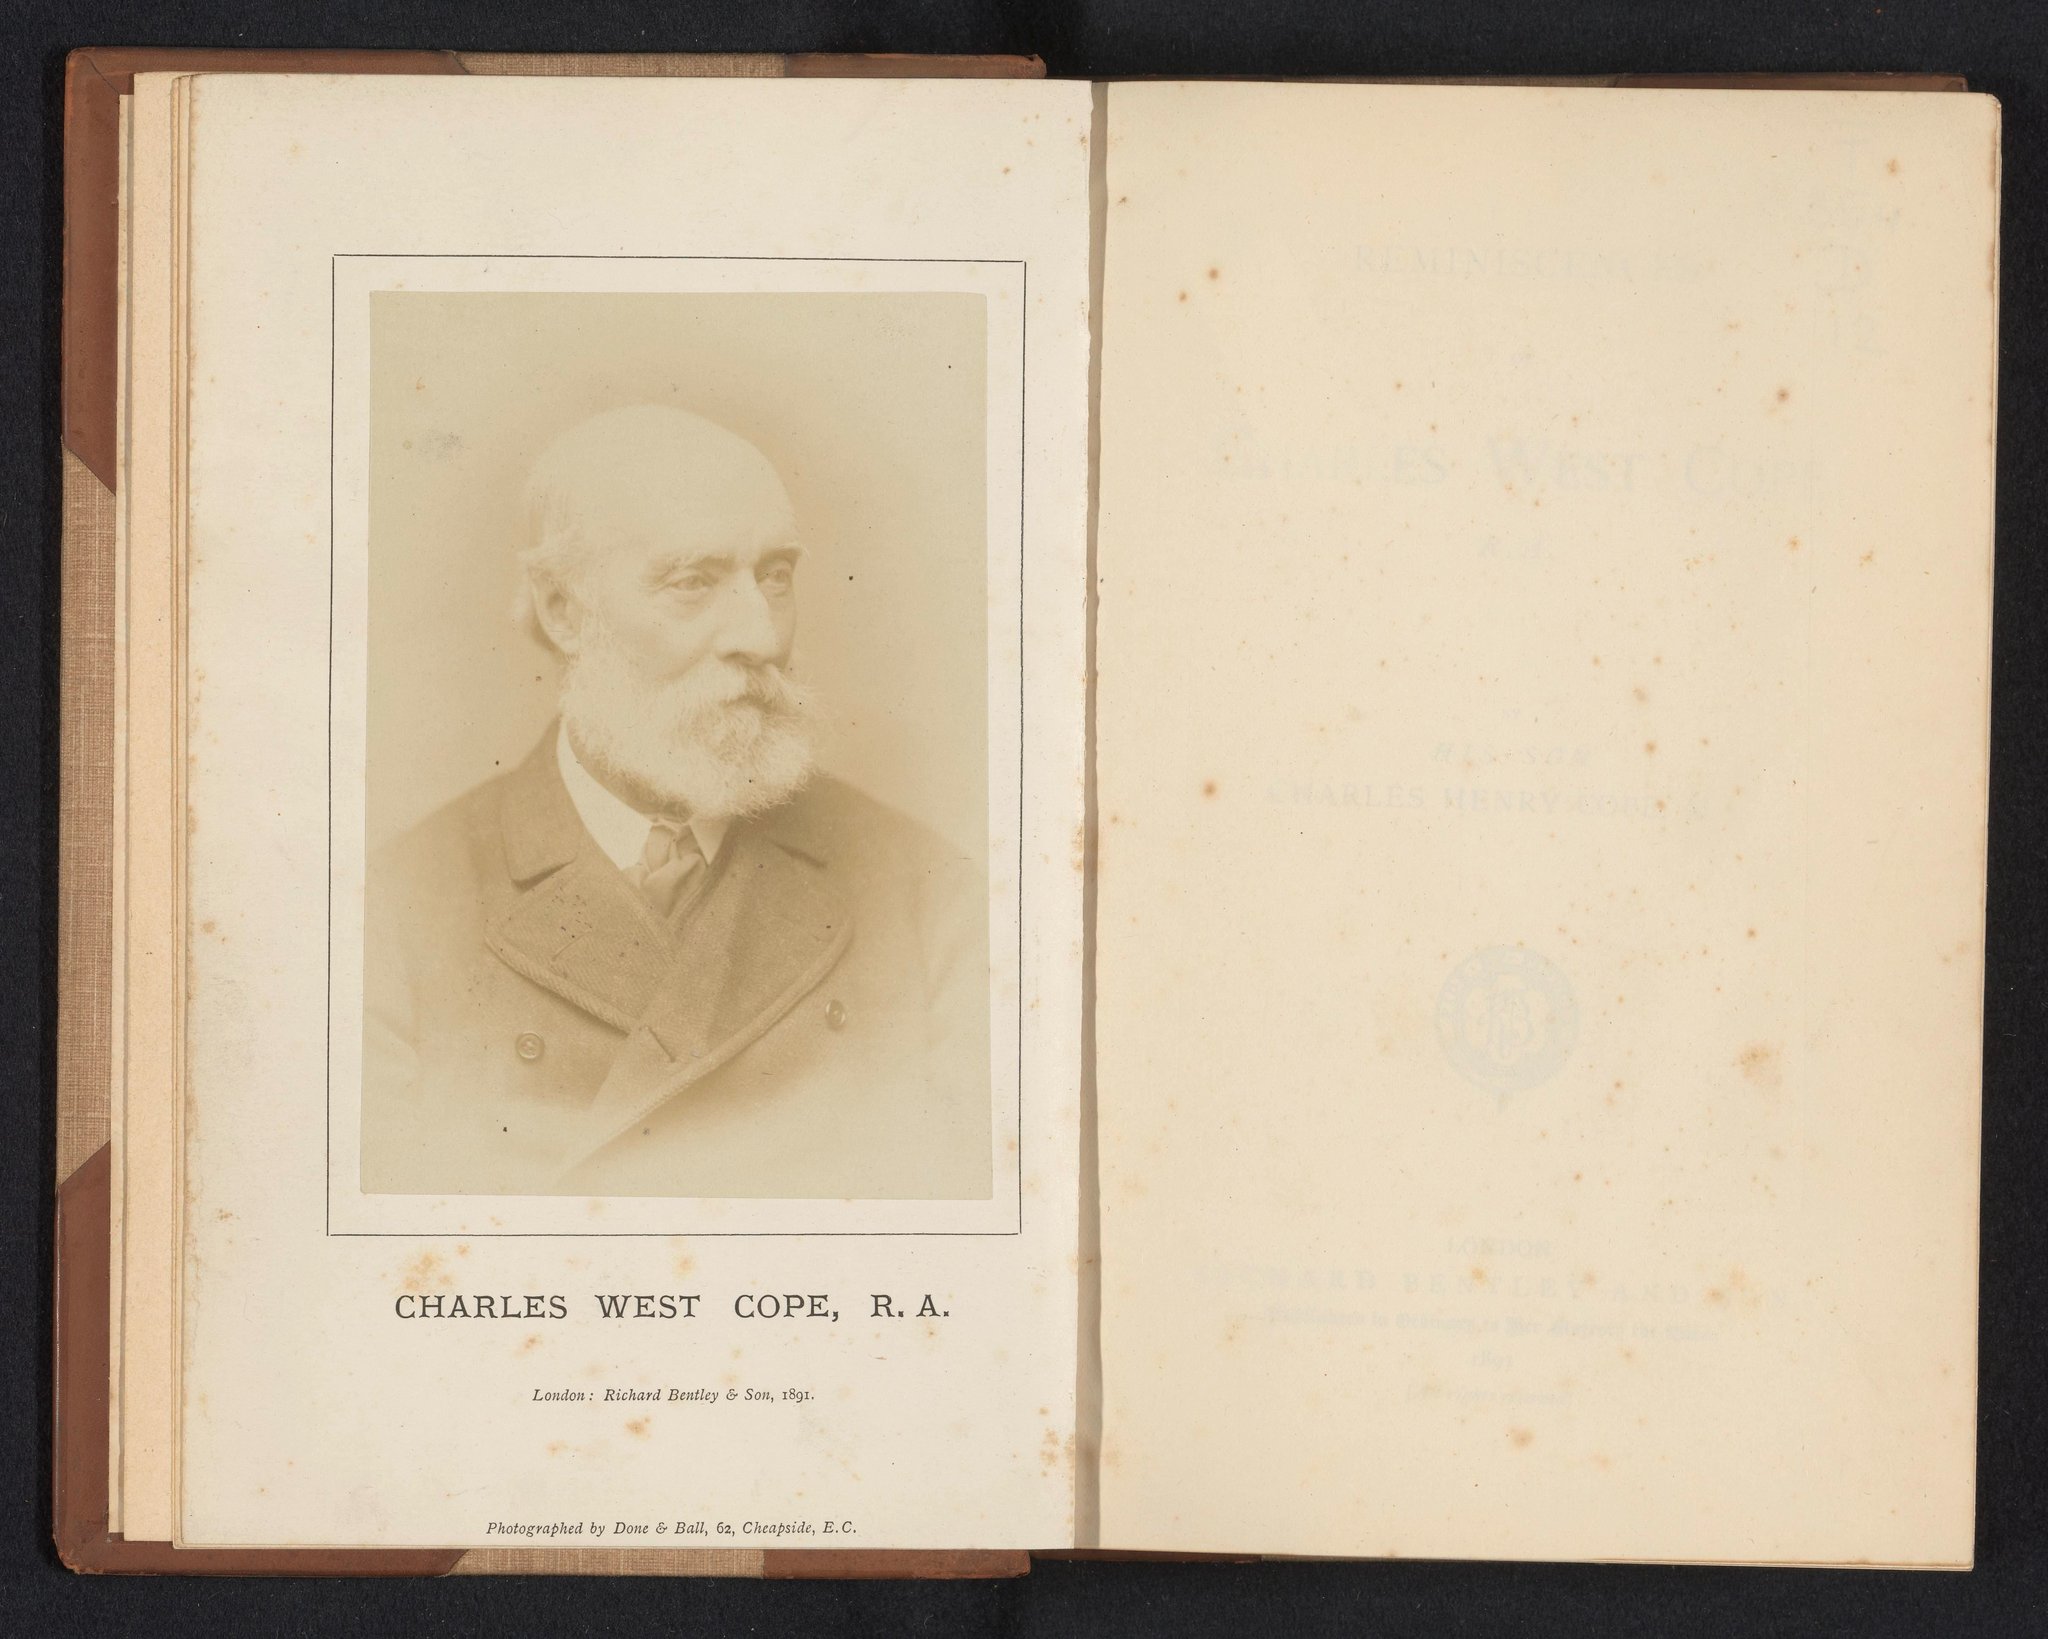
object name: page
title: Charles West Cope, R. A.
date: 1881-1891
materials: photographic support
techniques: albumen print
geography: london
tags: painter, portrait, self-portrait of artist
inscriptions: inscription: ‘Photographed by Done & Ball, 62, Cheapside, E.C.’